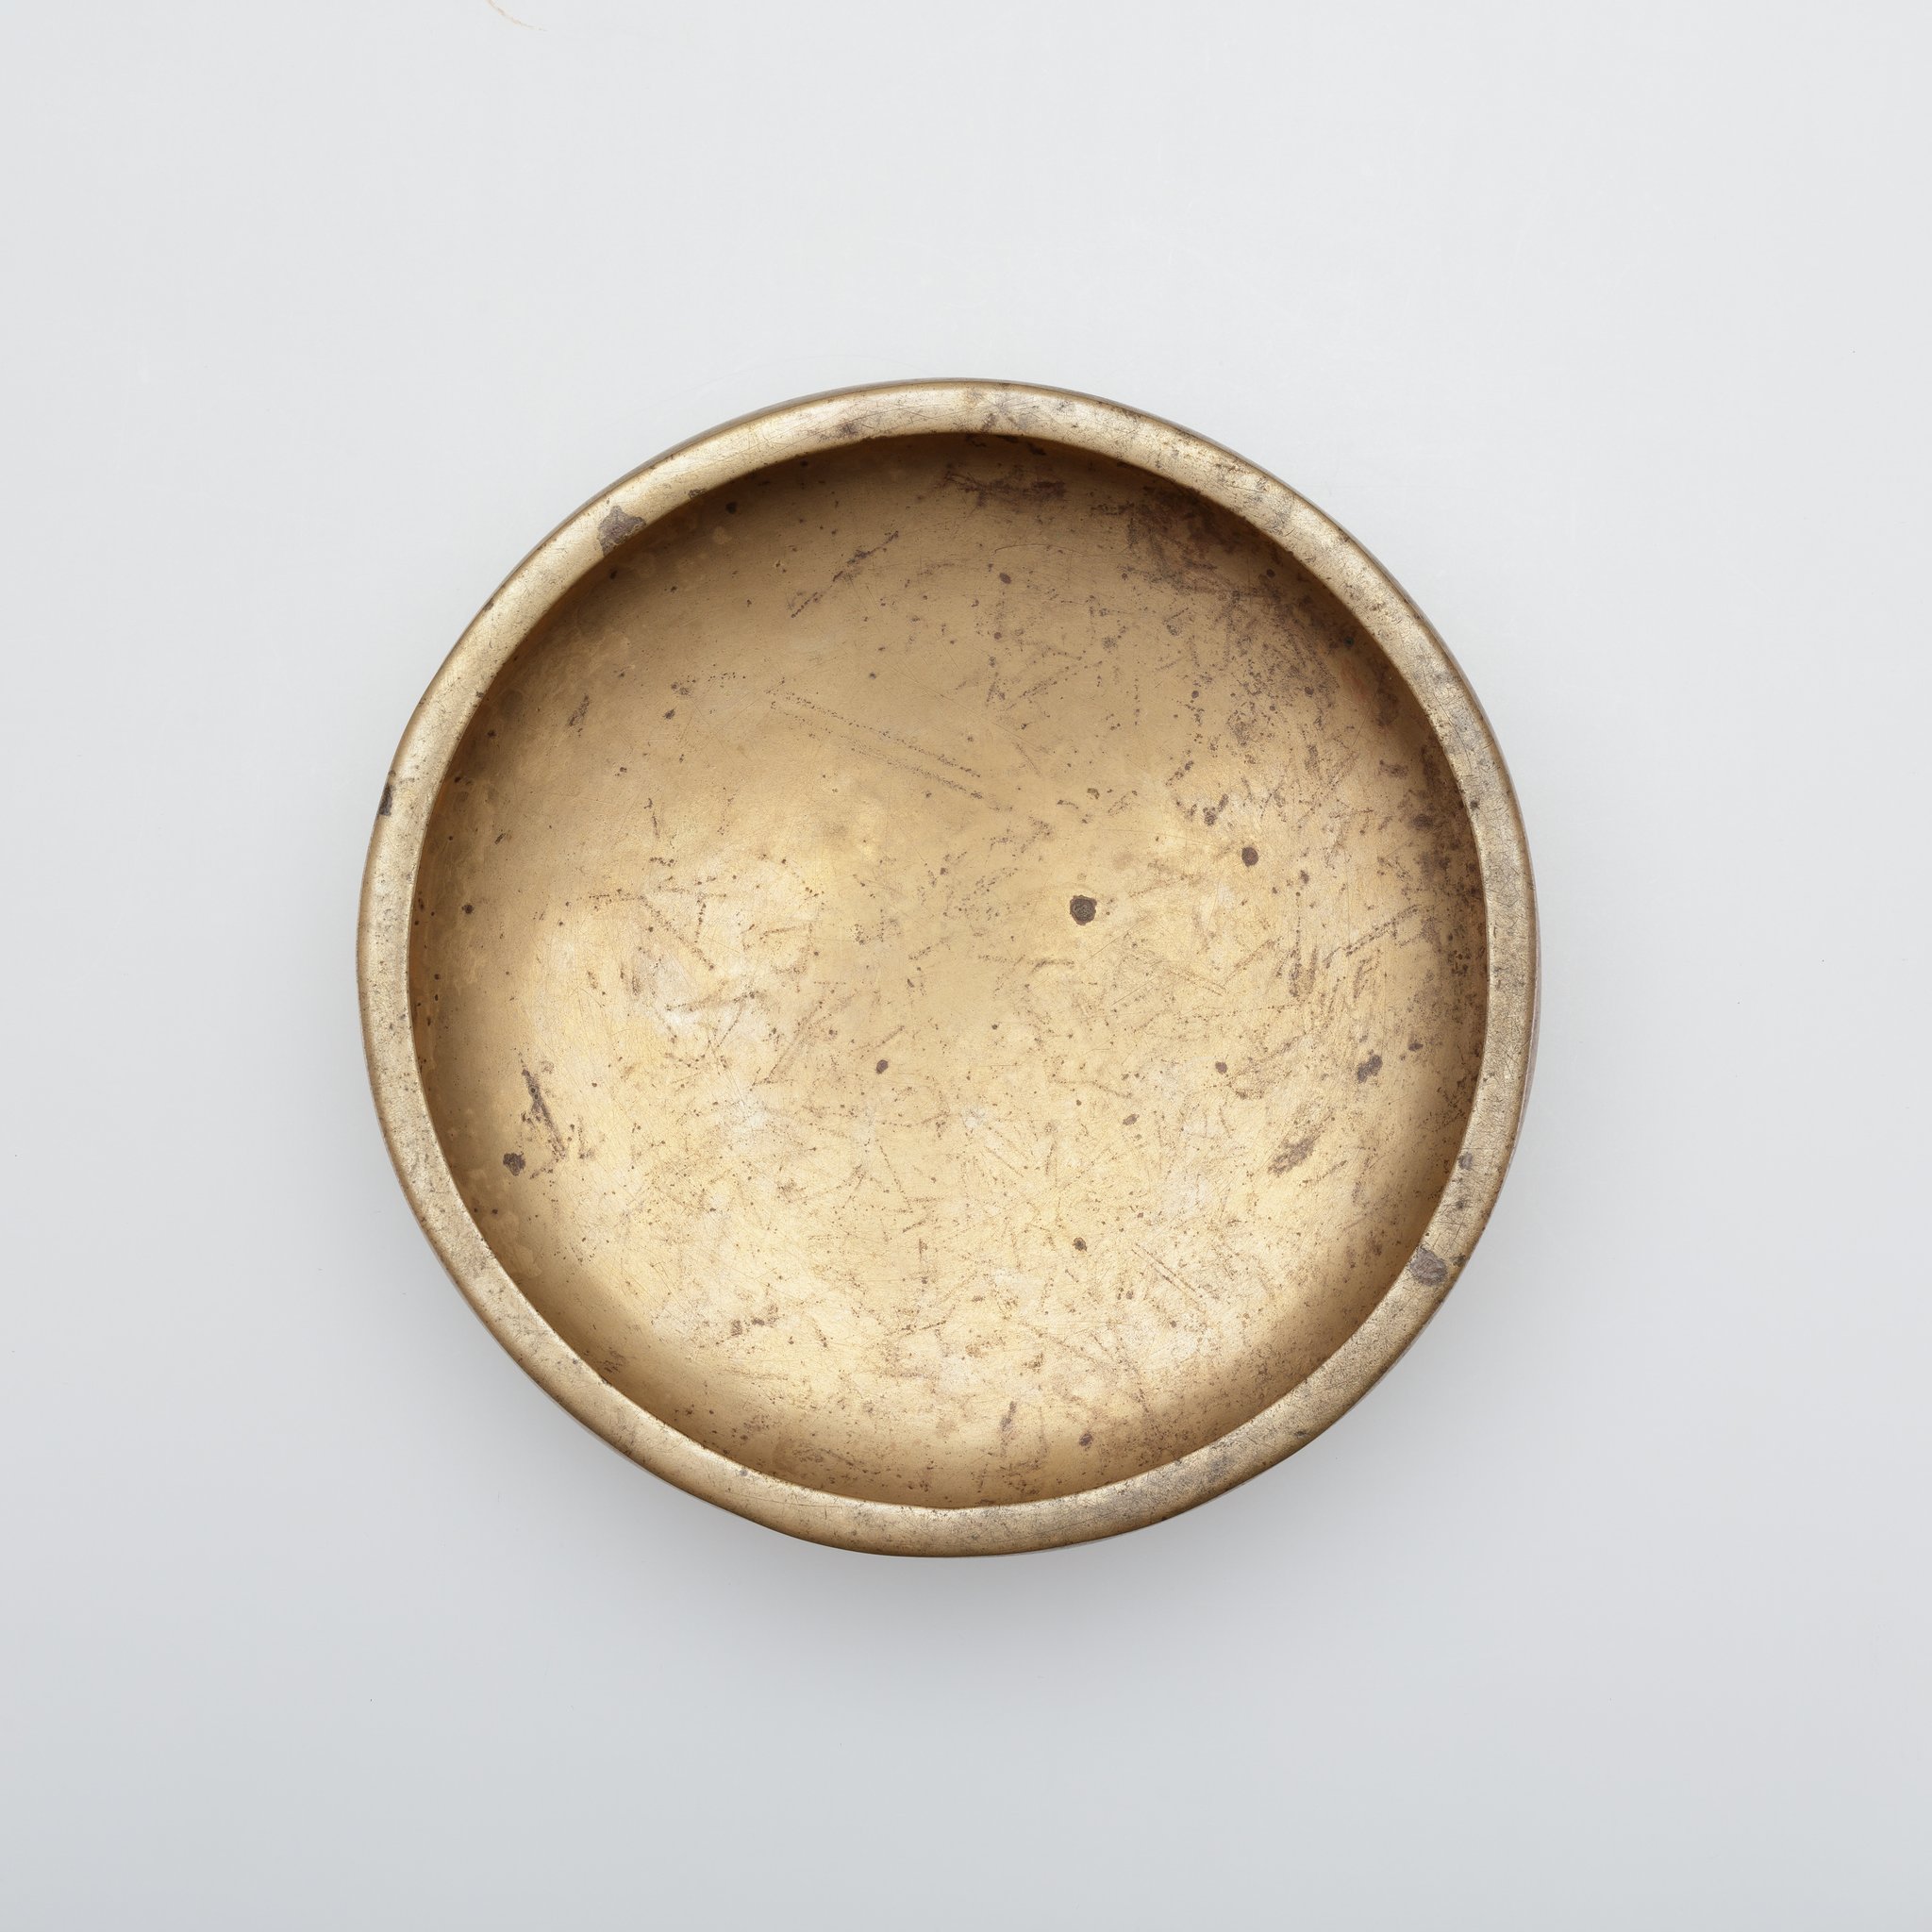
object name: bowl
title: One of five bowls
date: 1295-1070 BCE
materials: bronze, copper alloy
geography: egypt